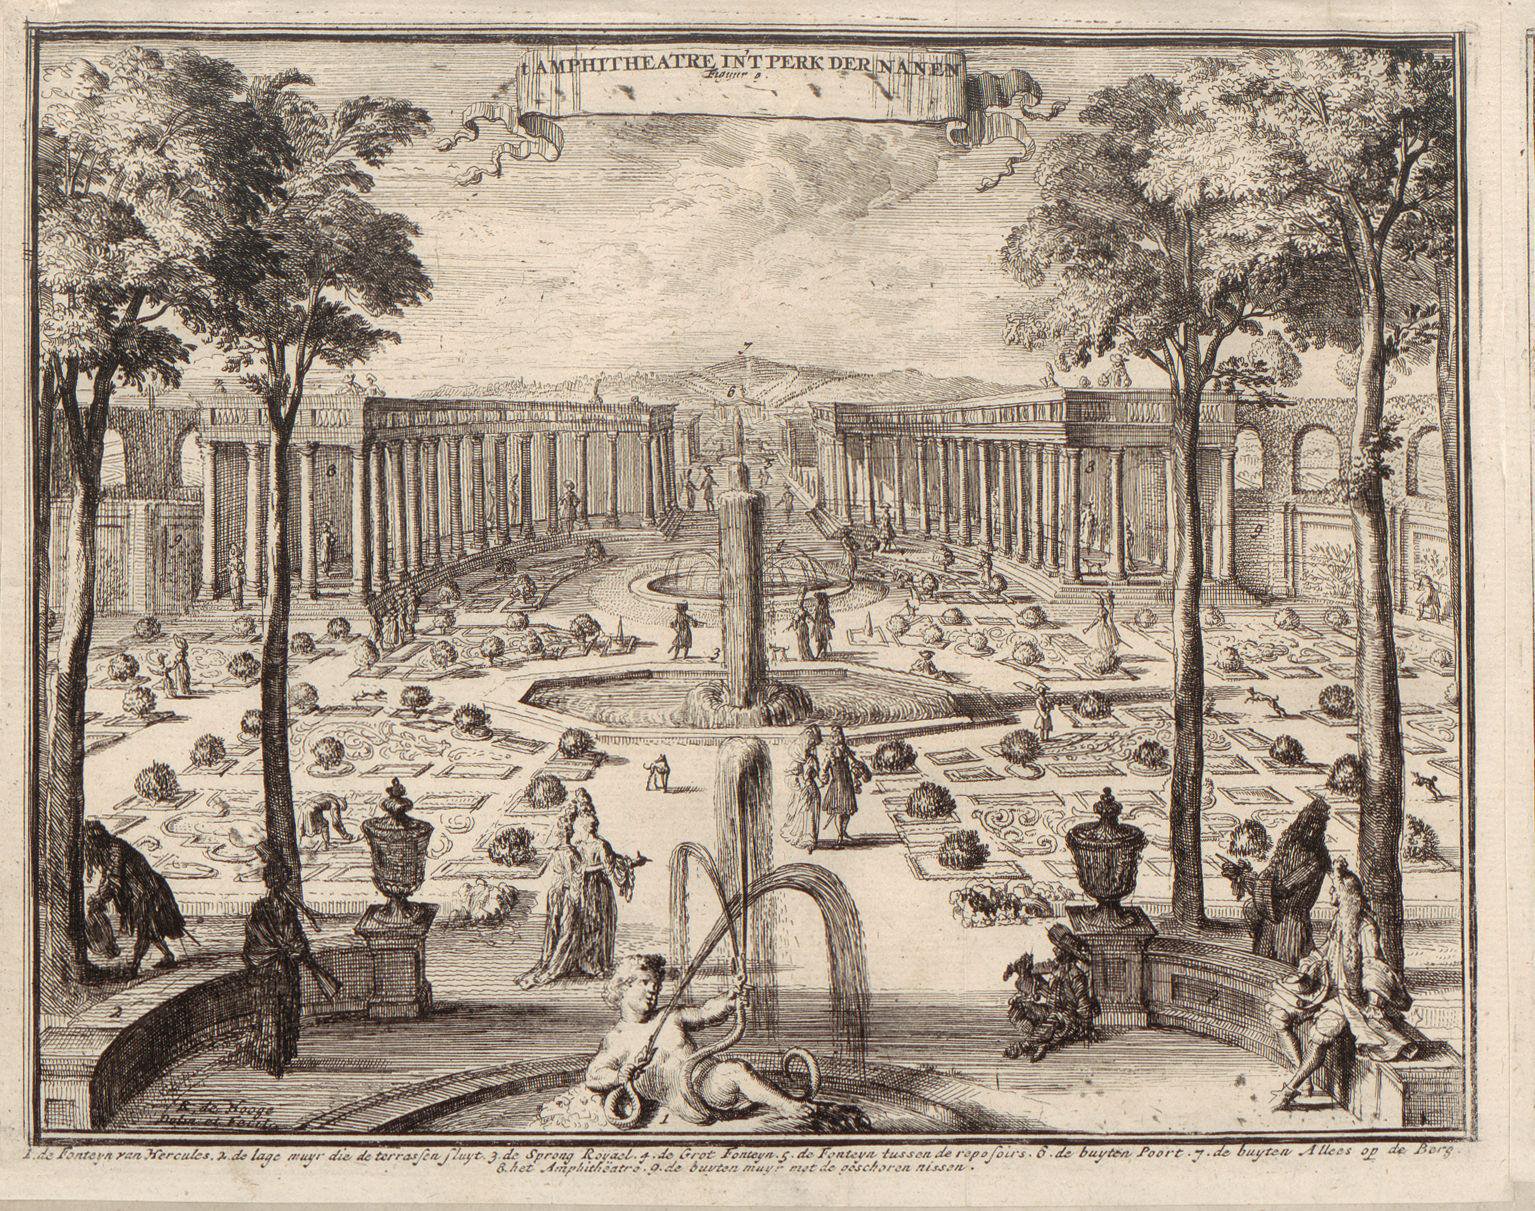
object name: print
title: Gezicht op twee zuilengalerijen in het park van Paleis Het Loo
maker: romeyn de hooghe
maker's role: draughtsman, goldsmith, painter, print maker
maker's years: 1645-1708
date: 1690-1694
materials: paper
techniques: etching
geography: haarlem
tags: william iii (prince of orange and king of england, scotland, and ireland), garden, garden fountain, palace, garden buildings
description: Gezicht op twee zuilengalerijen in het park van Paleis Het Loo. Eromheen en erin voorname wandelaars. In de marge onder de voorstelling een legenda in het Nederlands. Dit blad maakt deel uit van een omvangrijke prent met een gezicht op Paleis Het Loo, omgeven door dertien gezichten op de bijbehorende gebouwen en het bijbehorende park (boven, links, rechts), en een profiel van het paleis (onder).